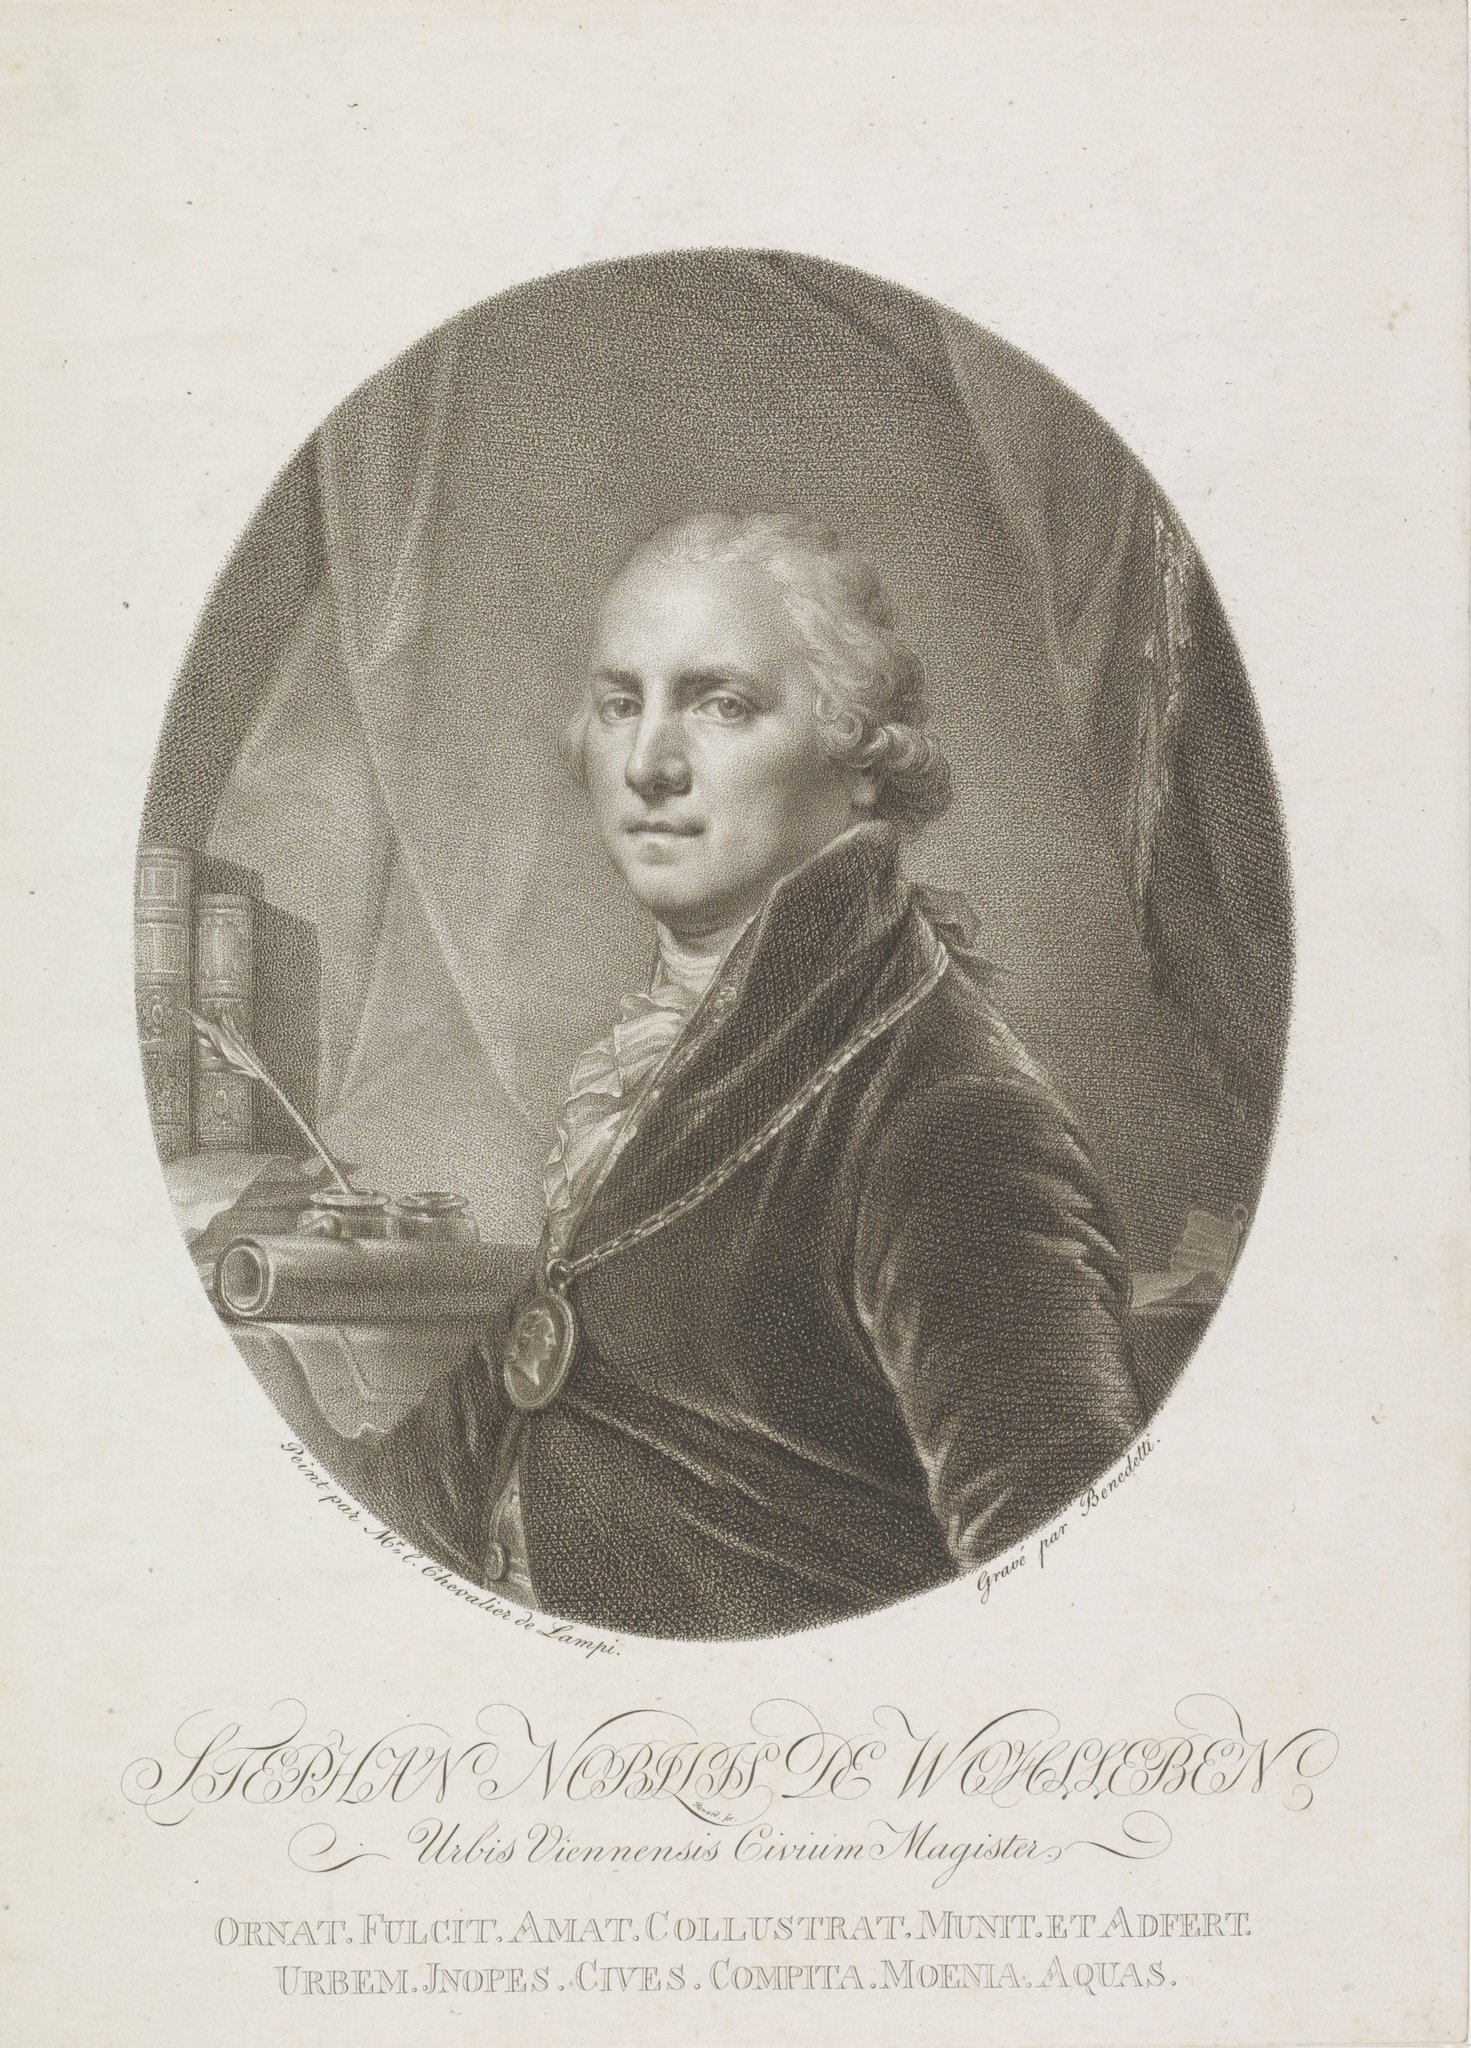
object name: print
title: Portret van Stephan Edler von Wohlleben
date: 1806-1863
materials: paper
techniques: engraving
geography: italy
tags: mayor, mayor, burgomaster, historical persons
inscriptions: collector's mark: Lugt 2760, collector's mark: Lugt 2228